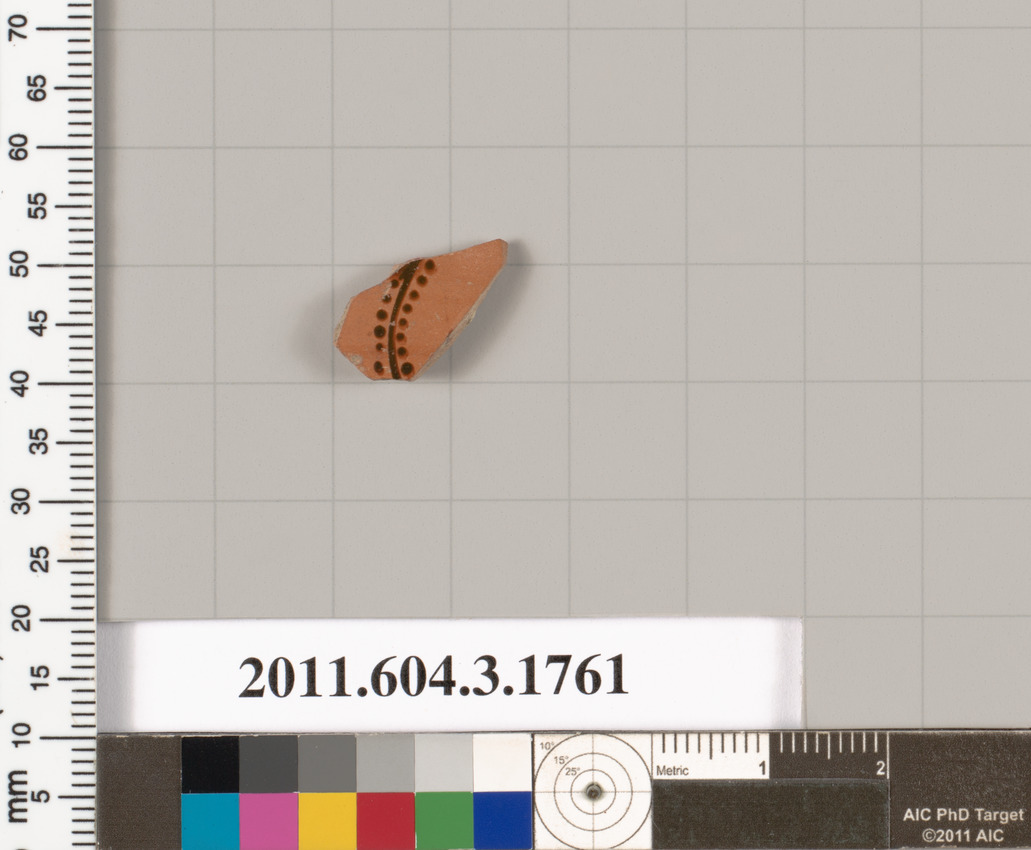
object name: kylix fragment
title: Terracotta fragment of a kylix: Band or lip cup (drinking cup)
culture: greek, attic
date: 550-526 BCE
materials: terracotta